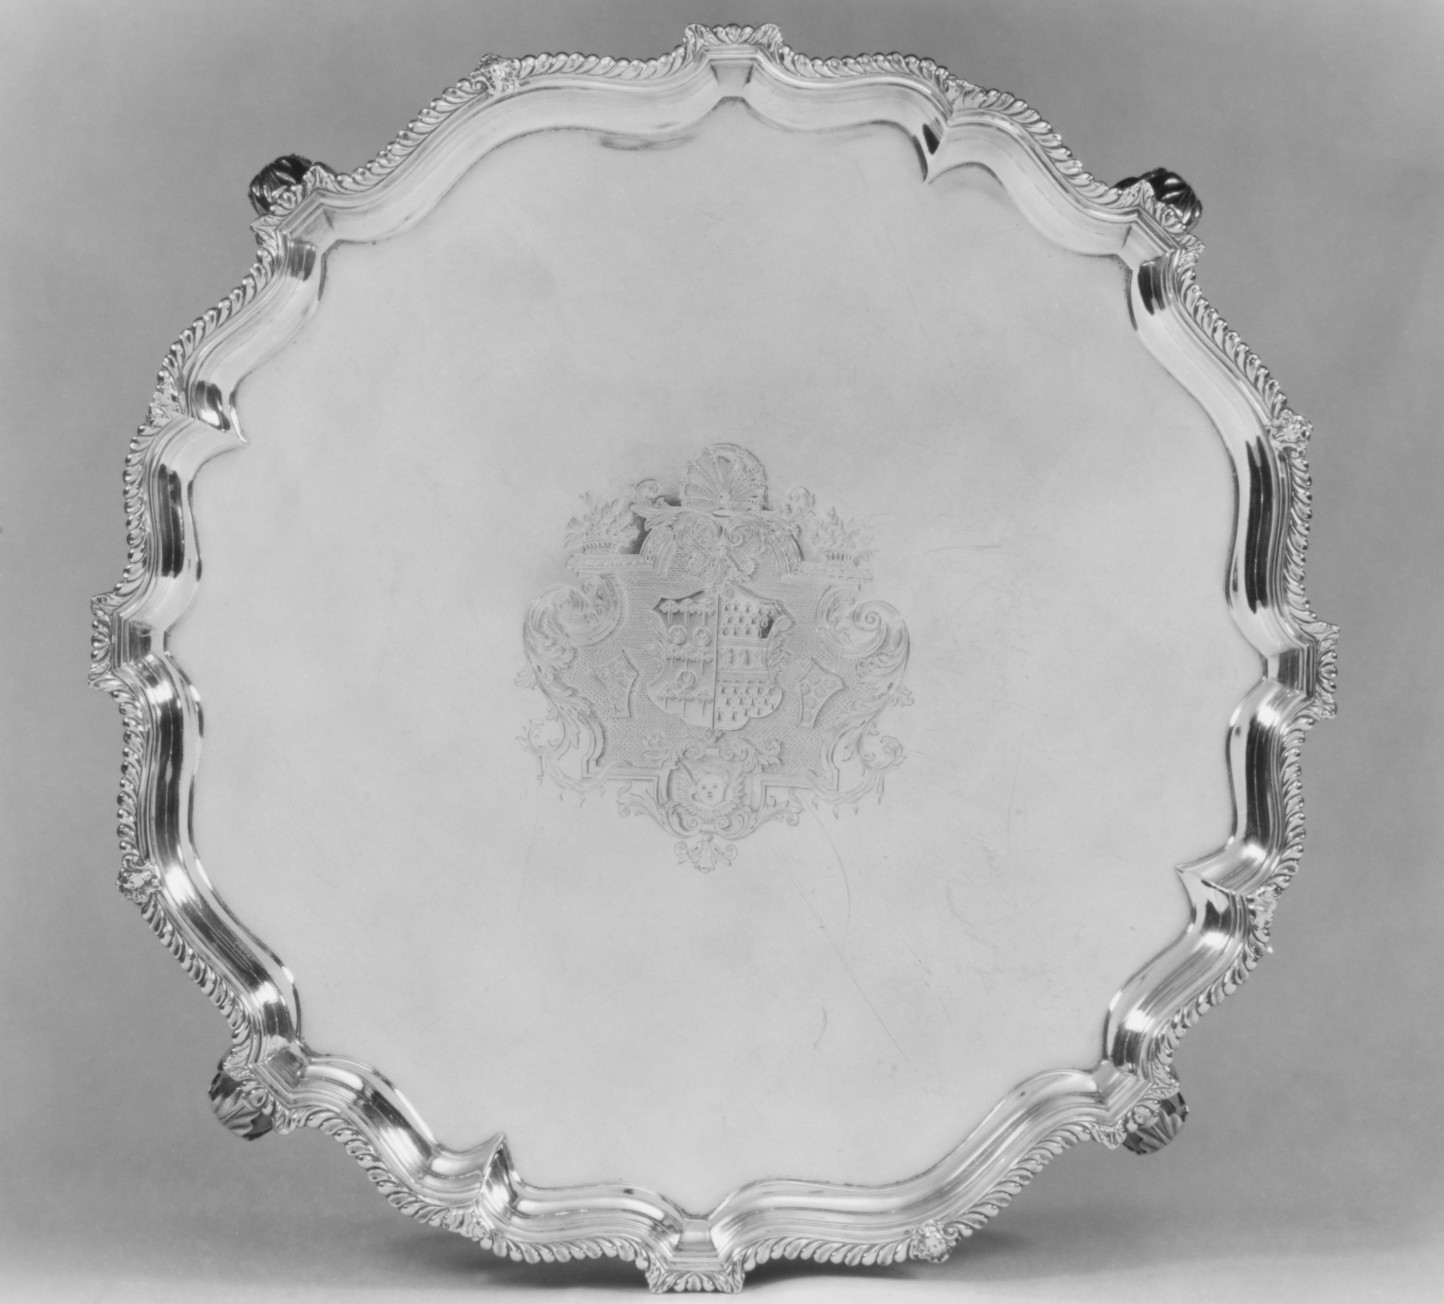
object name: salver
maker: george wickes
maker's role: maker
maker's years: 1698-1761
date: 1732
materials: silver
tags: coat of arms